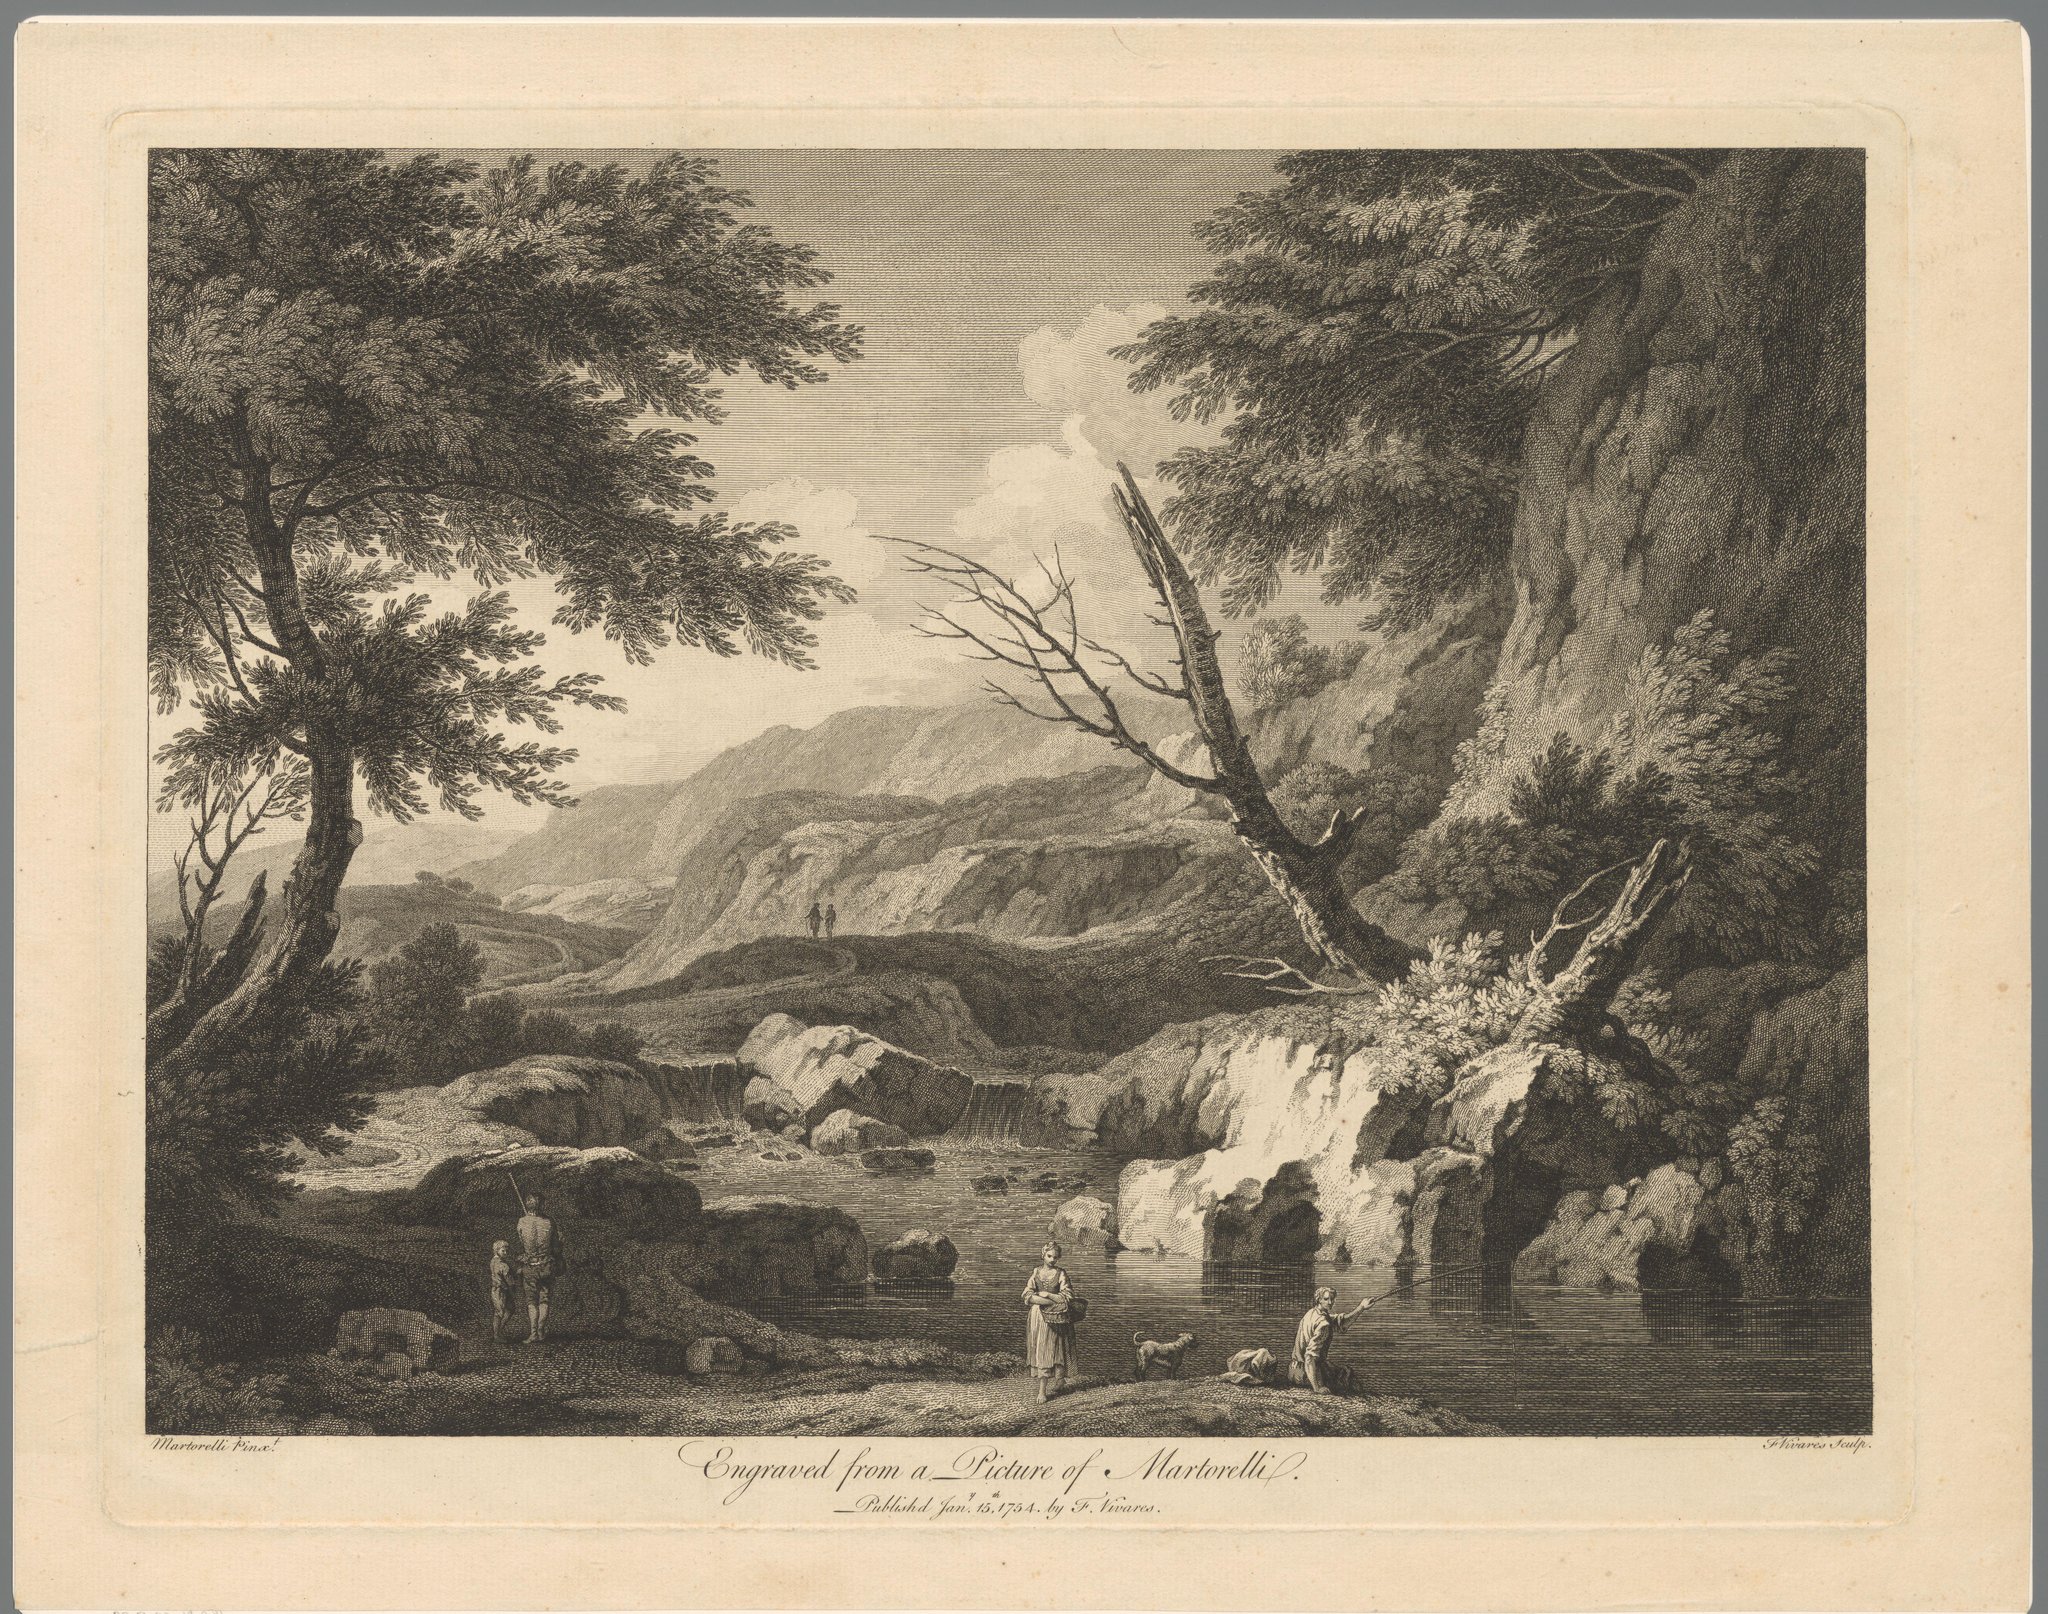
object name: print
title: Heuvellandschap met figuren bij een rivier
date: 1754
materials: paper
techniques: etching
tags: rapids (+ landscape with figures, staffage), rock-formations (+ landscape with figures, staffage)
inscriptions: collector's mark: Lugt 2228